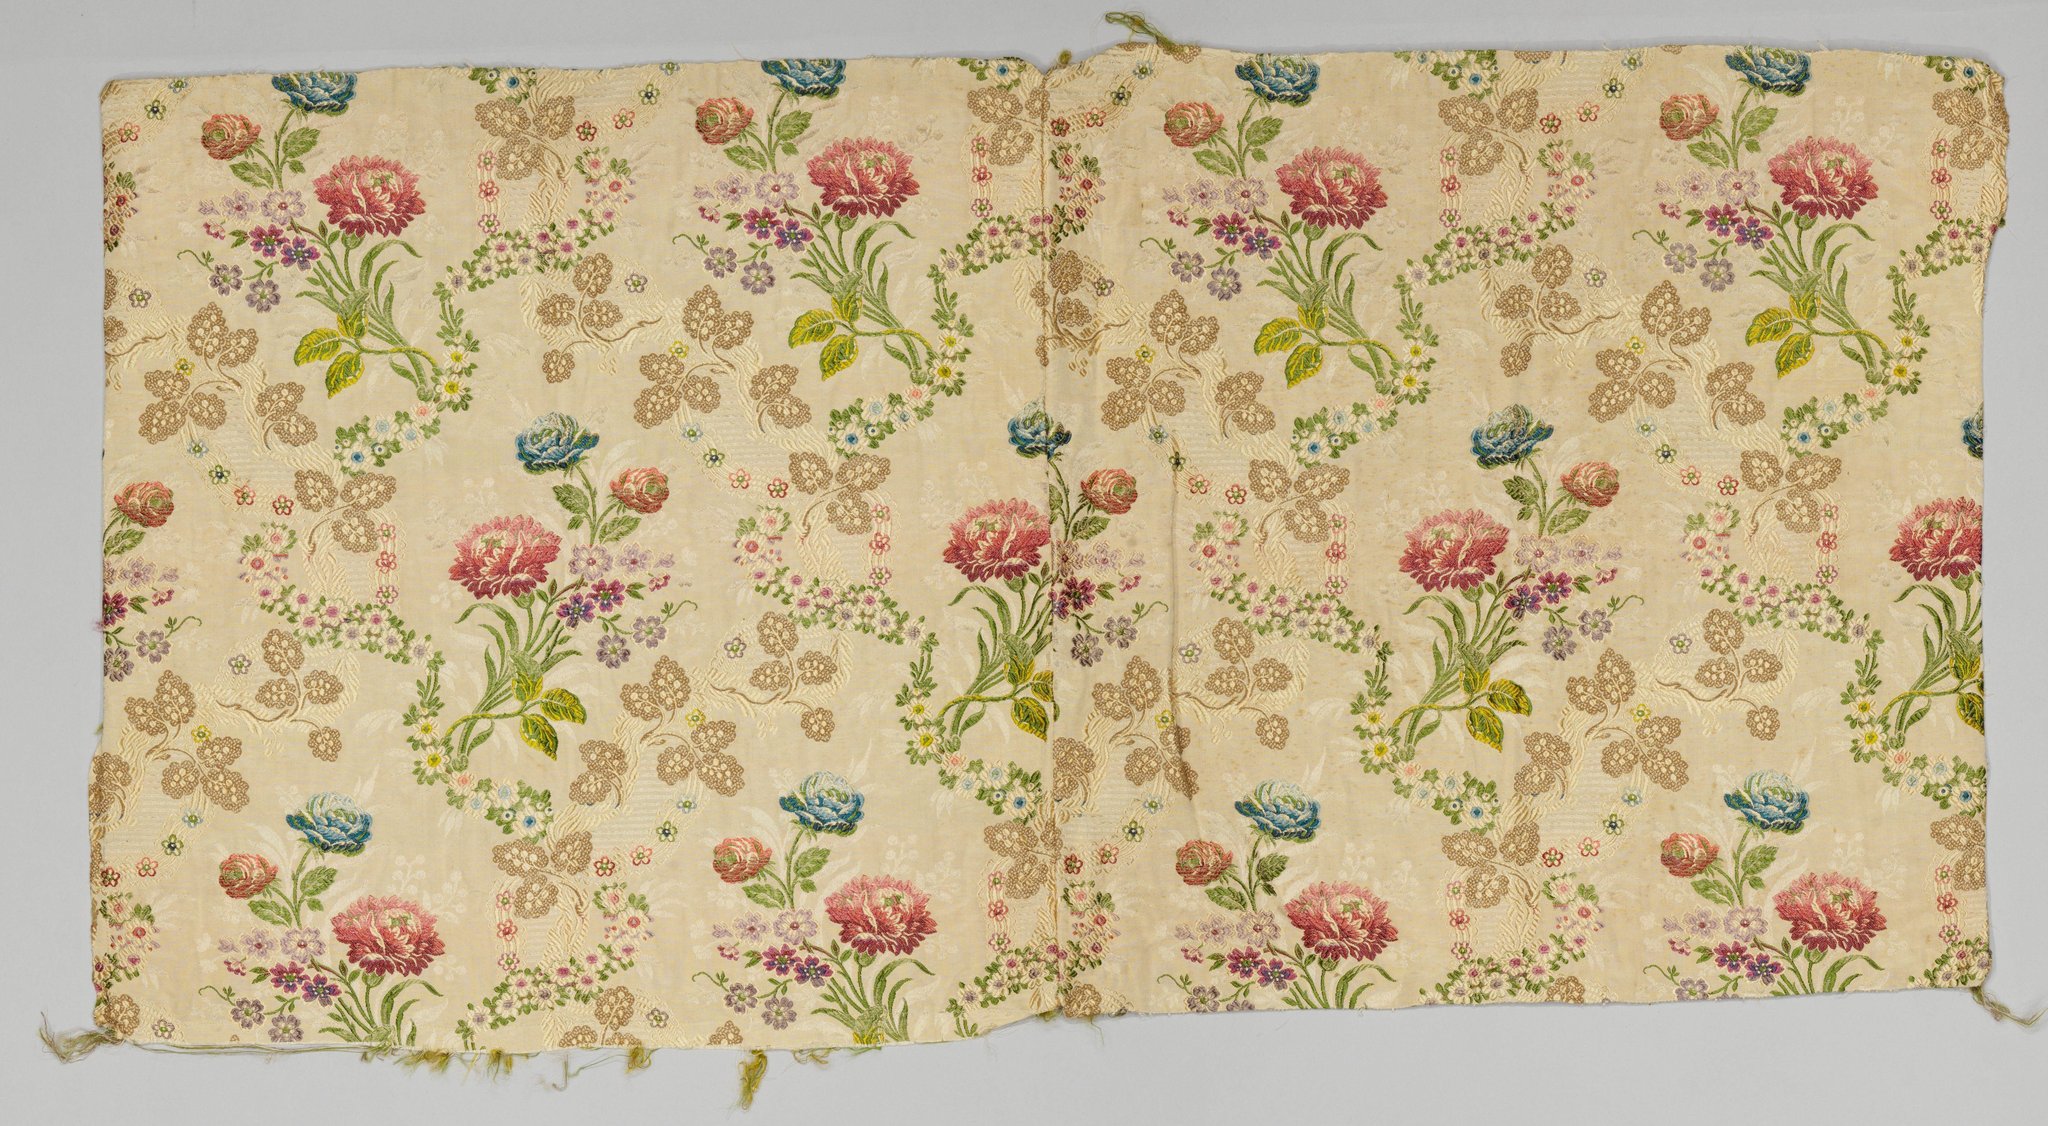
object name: silk textile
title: Fragment veelkleurig zijdeweefsel met floraal patroon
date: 1840-1870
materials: silk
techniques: lampas, weave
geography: france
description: Fragment veelkleurig zijdeweefsel. Een witte grond heeft witte kantslingers met bruine bladeren, waartussen veelkleurige bloemboeketten en bloemslingers.